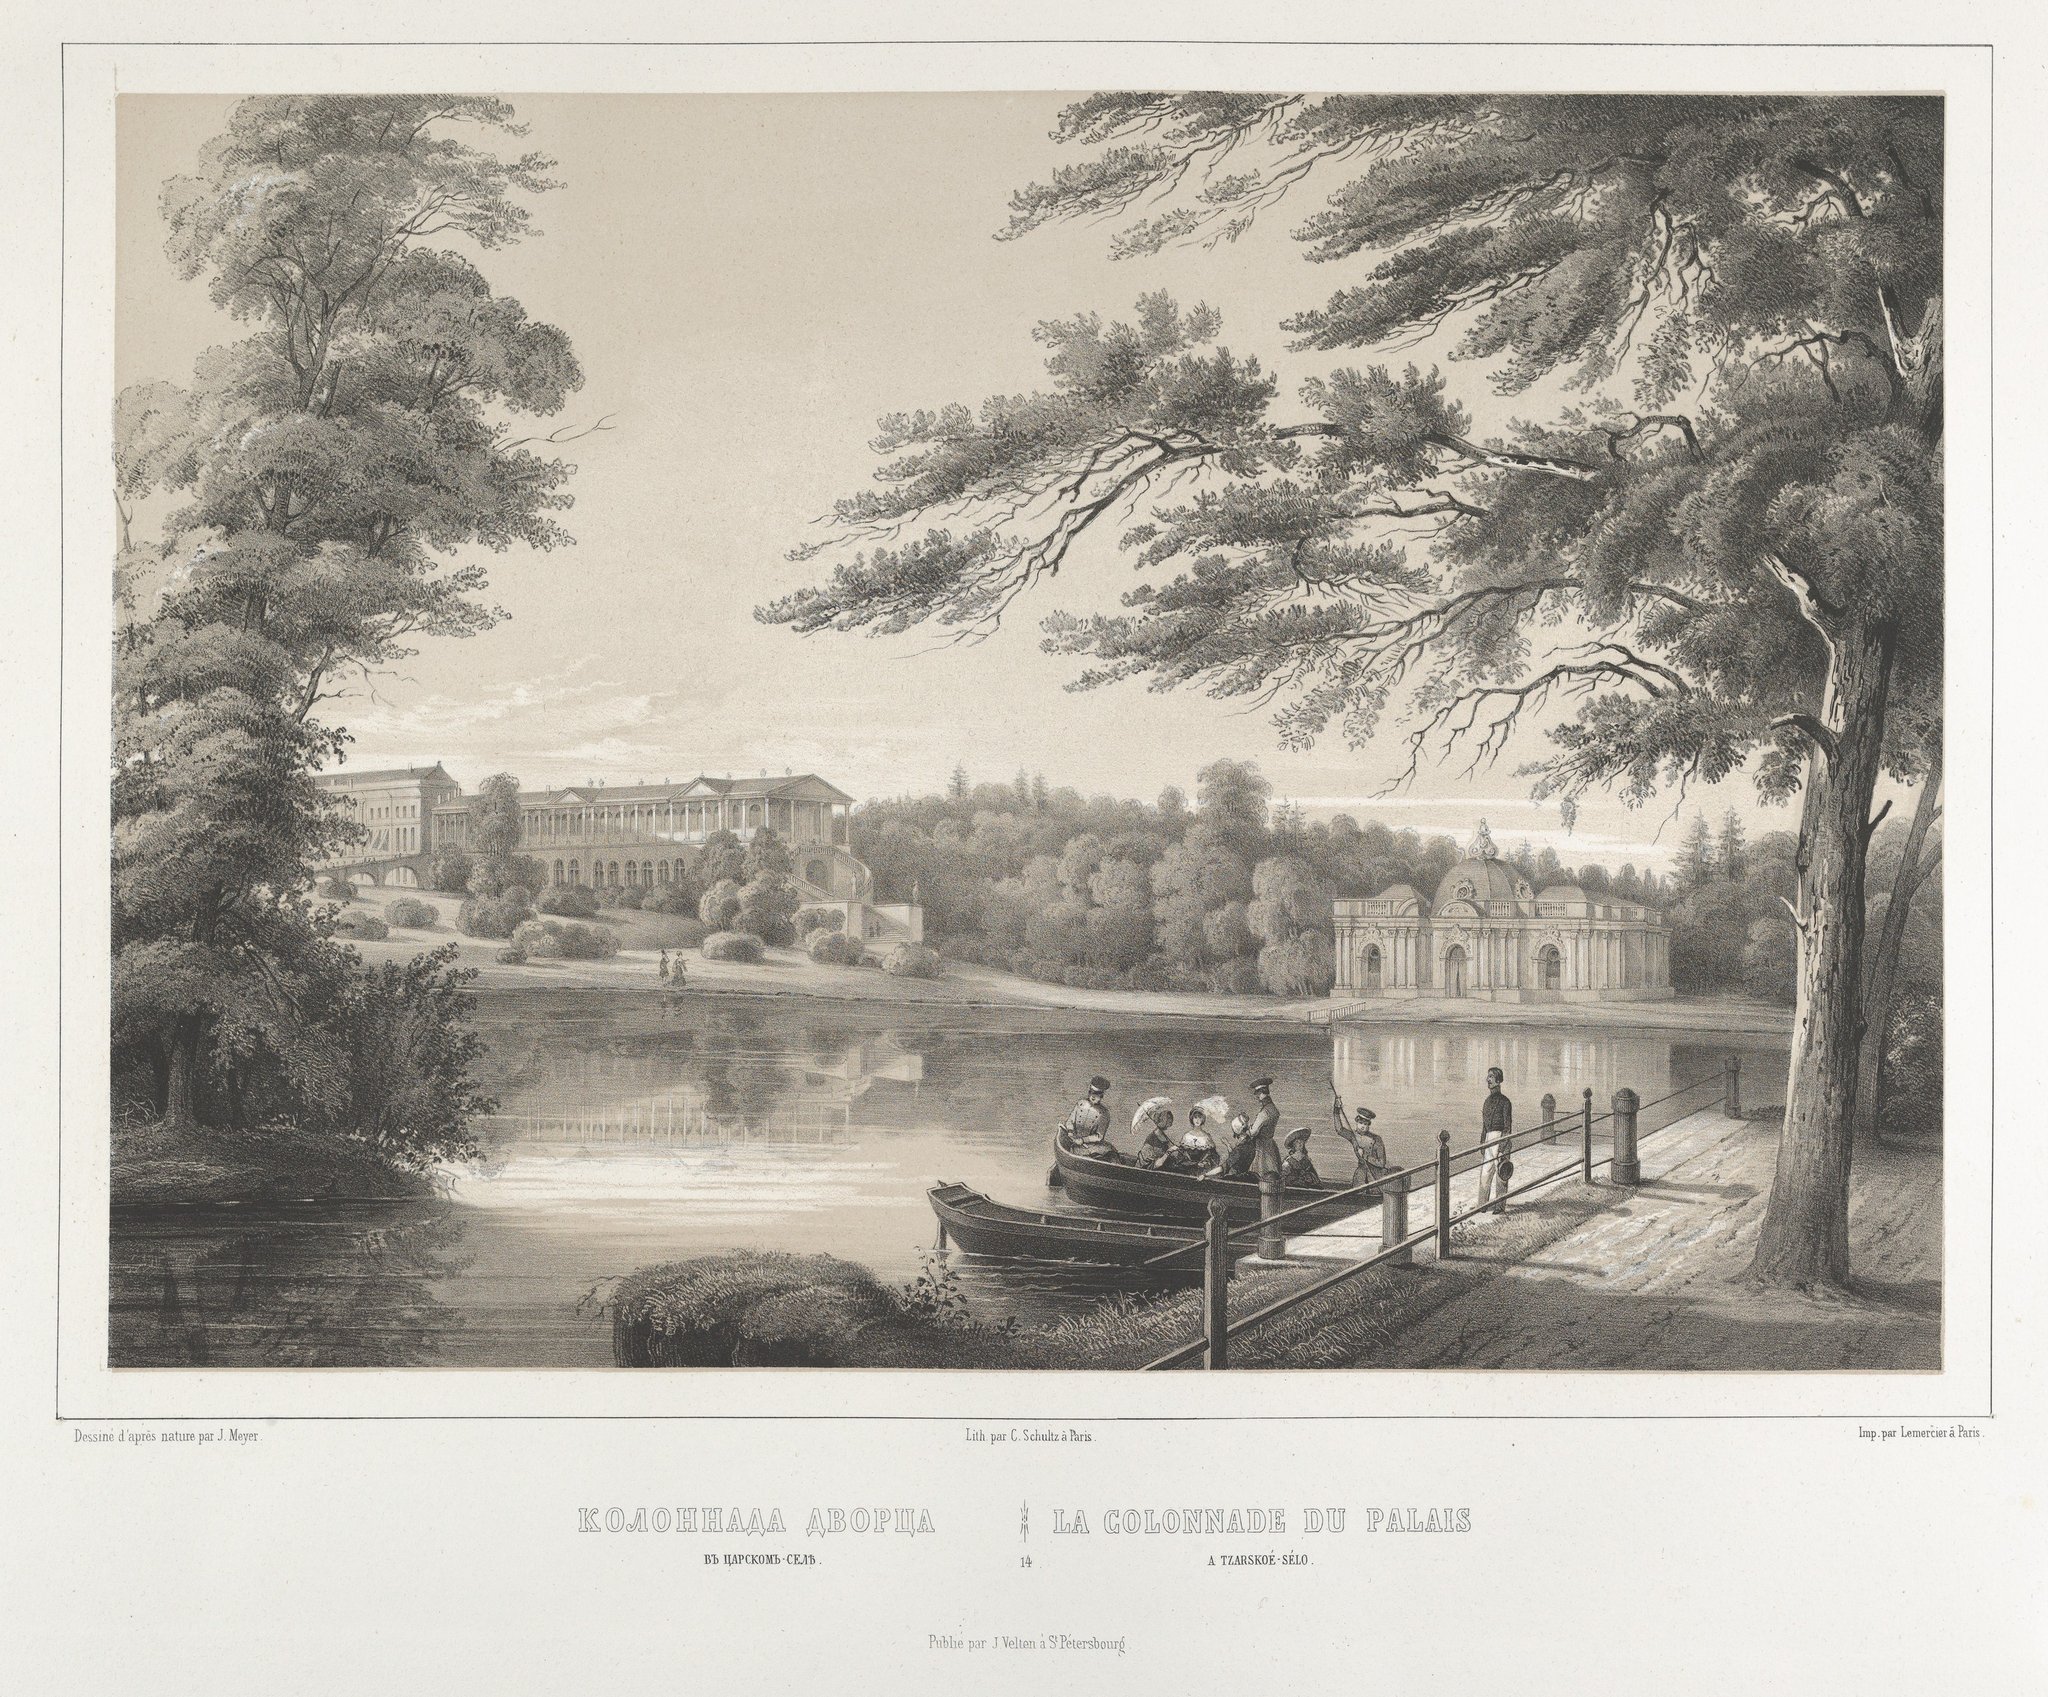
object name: print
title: La Colonnade du Palais a Tzarskoé-Sélo, from "Vues pittoresques des palais & jardins impériaux aux environs de St. Petersbourg"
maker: j. meyer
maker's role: artist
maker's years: 1800-1900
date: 1850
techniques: lithograph, printing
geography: st. petersburg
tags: palaces,boats